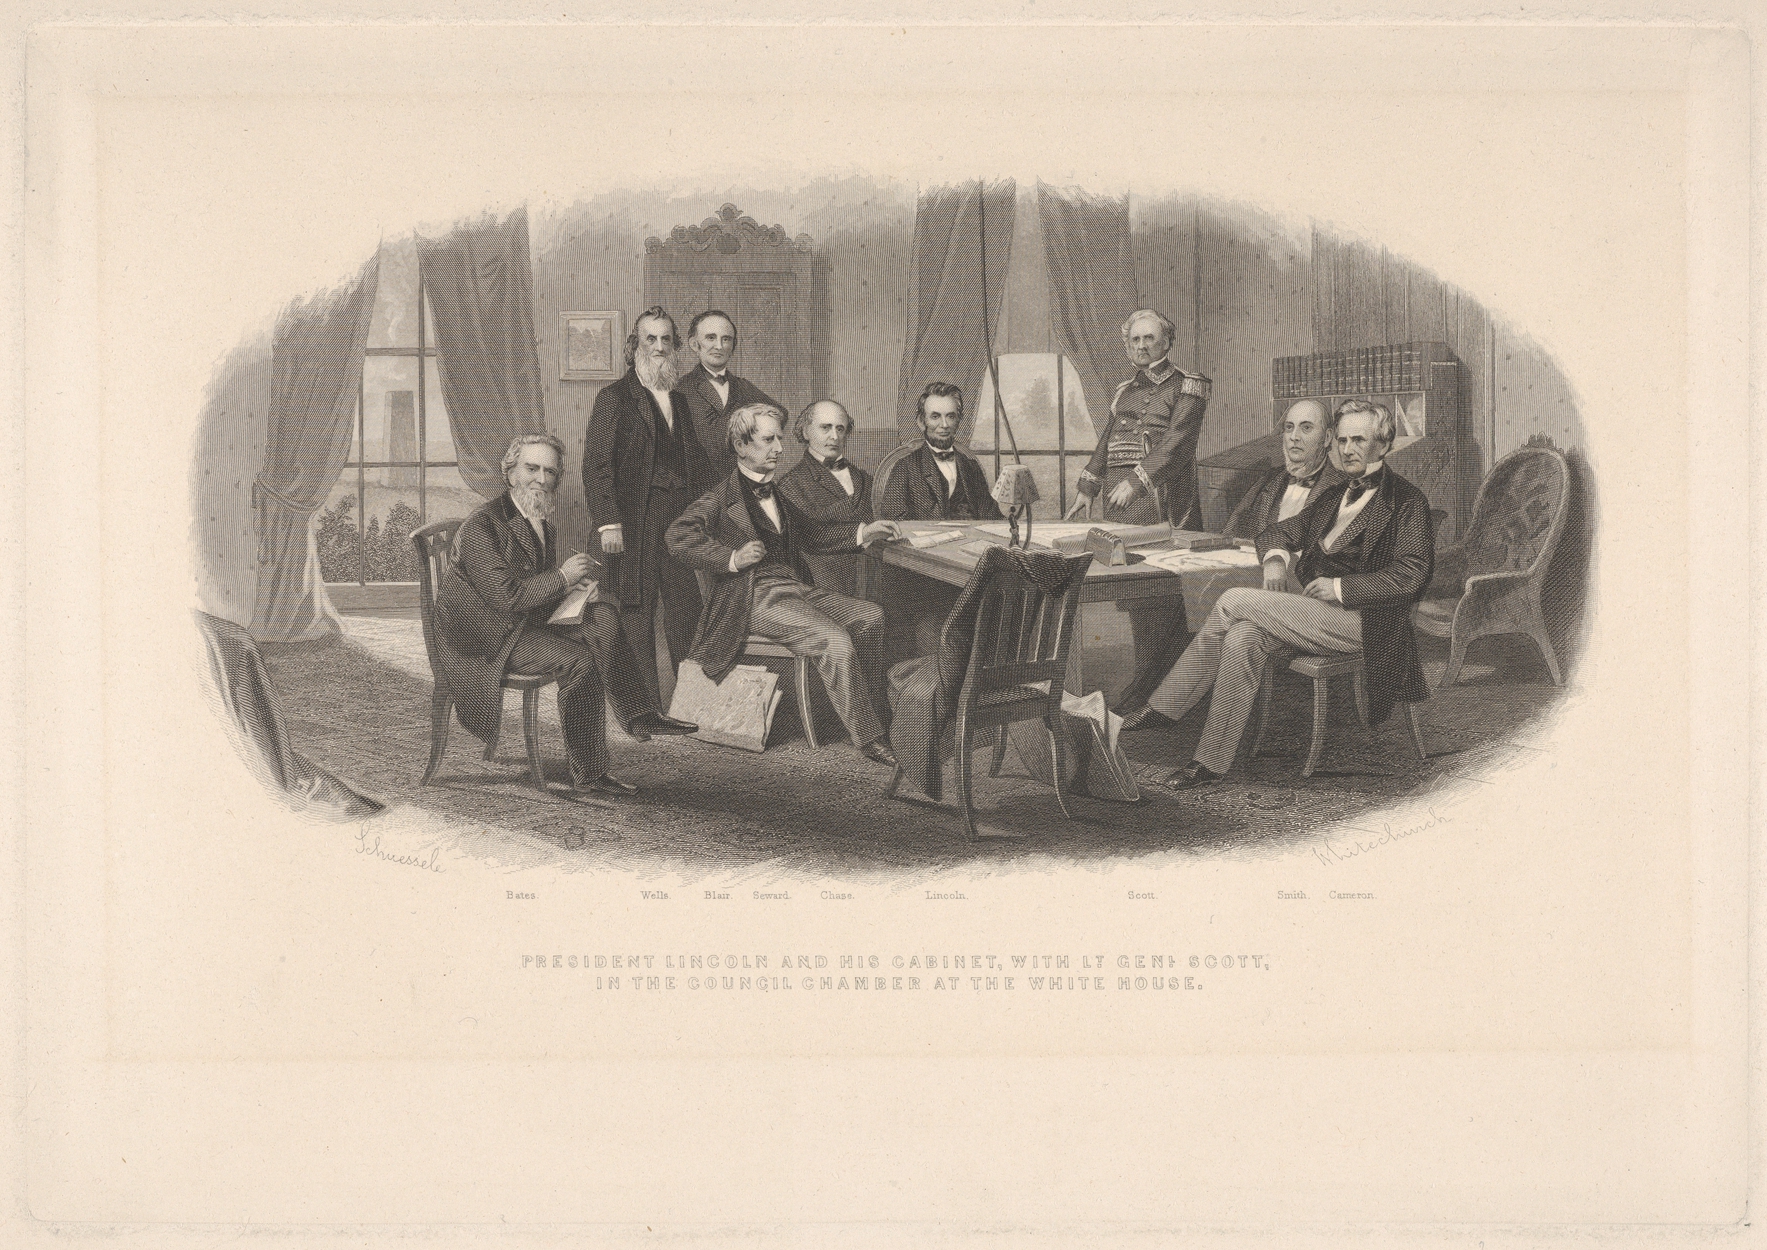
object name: drawing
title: President Lincoln and His Cabinet, with Lt. General Scott, in the Council Chamber at the White House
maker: robert whitechurch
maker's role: engraver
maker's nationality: american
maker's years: 1814-1876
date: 1861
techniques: engraving, etching, stippling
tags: abraham lincoln,men,generals